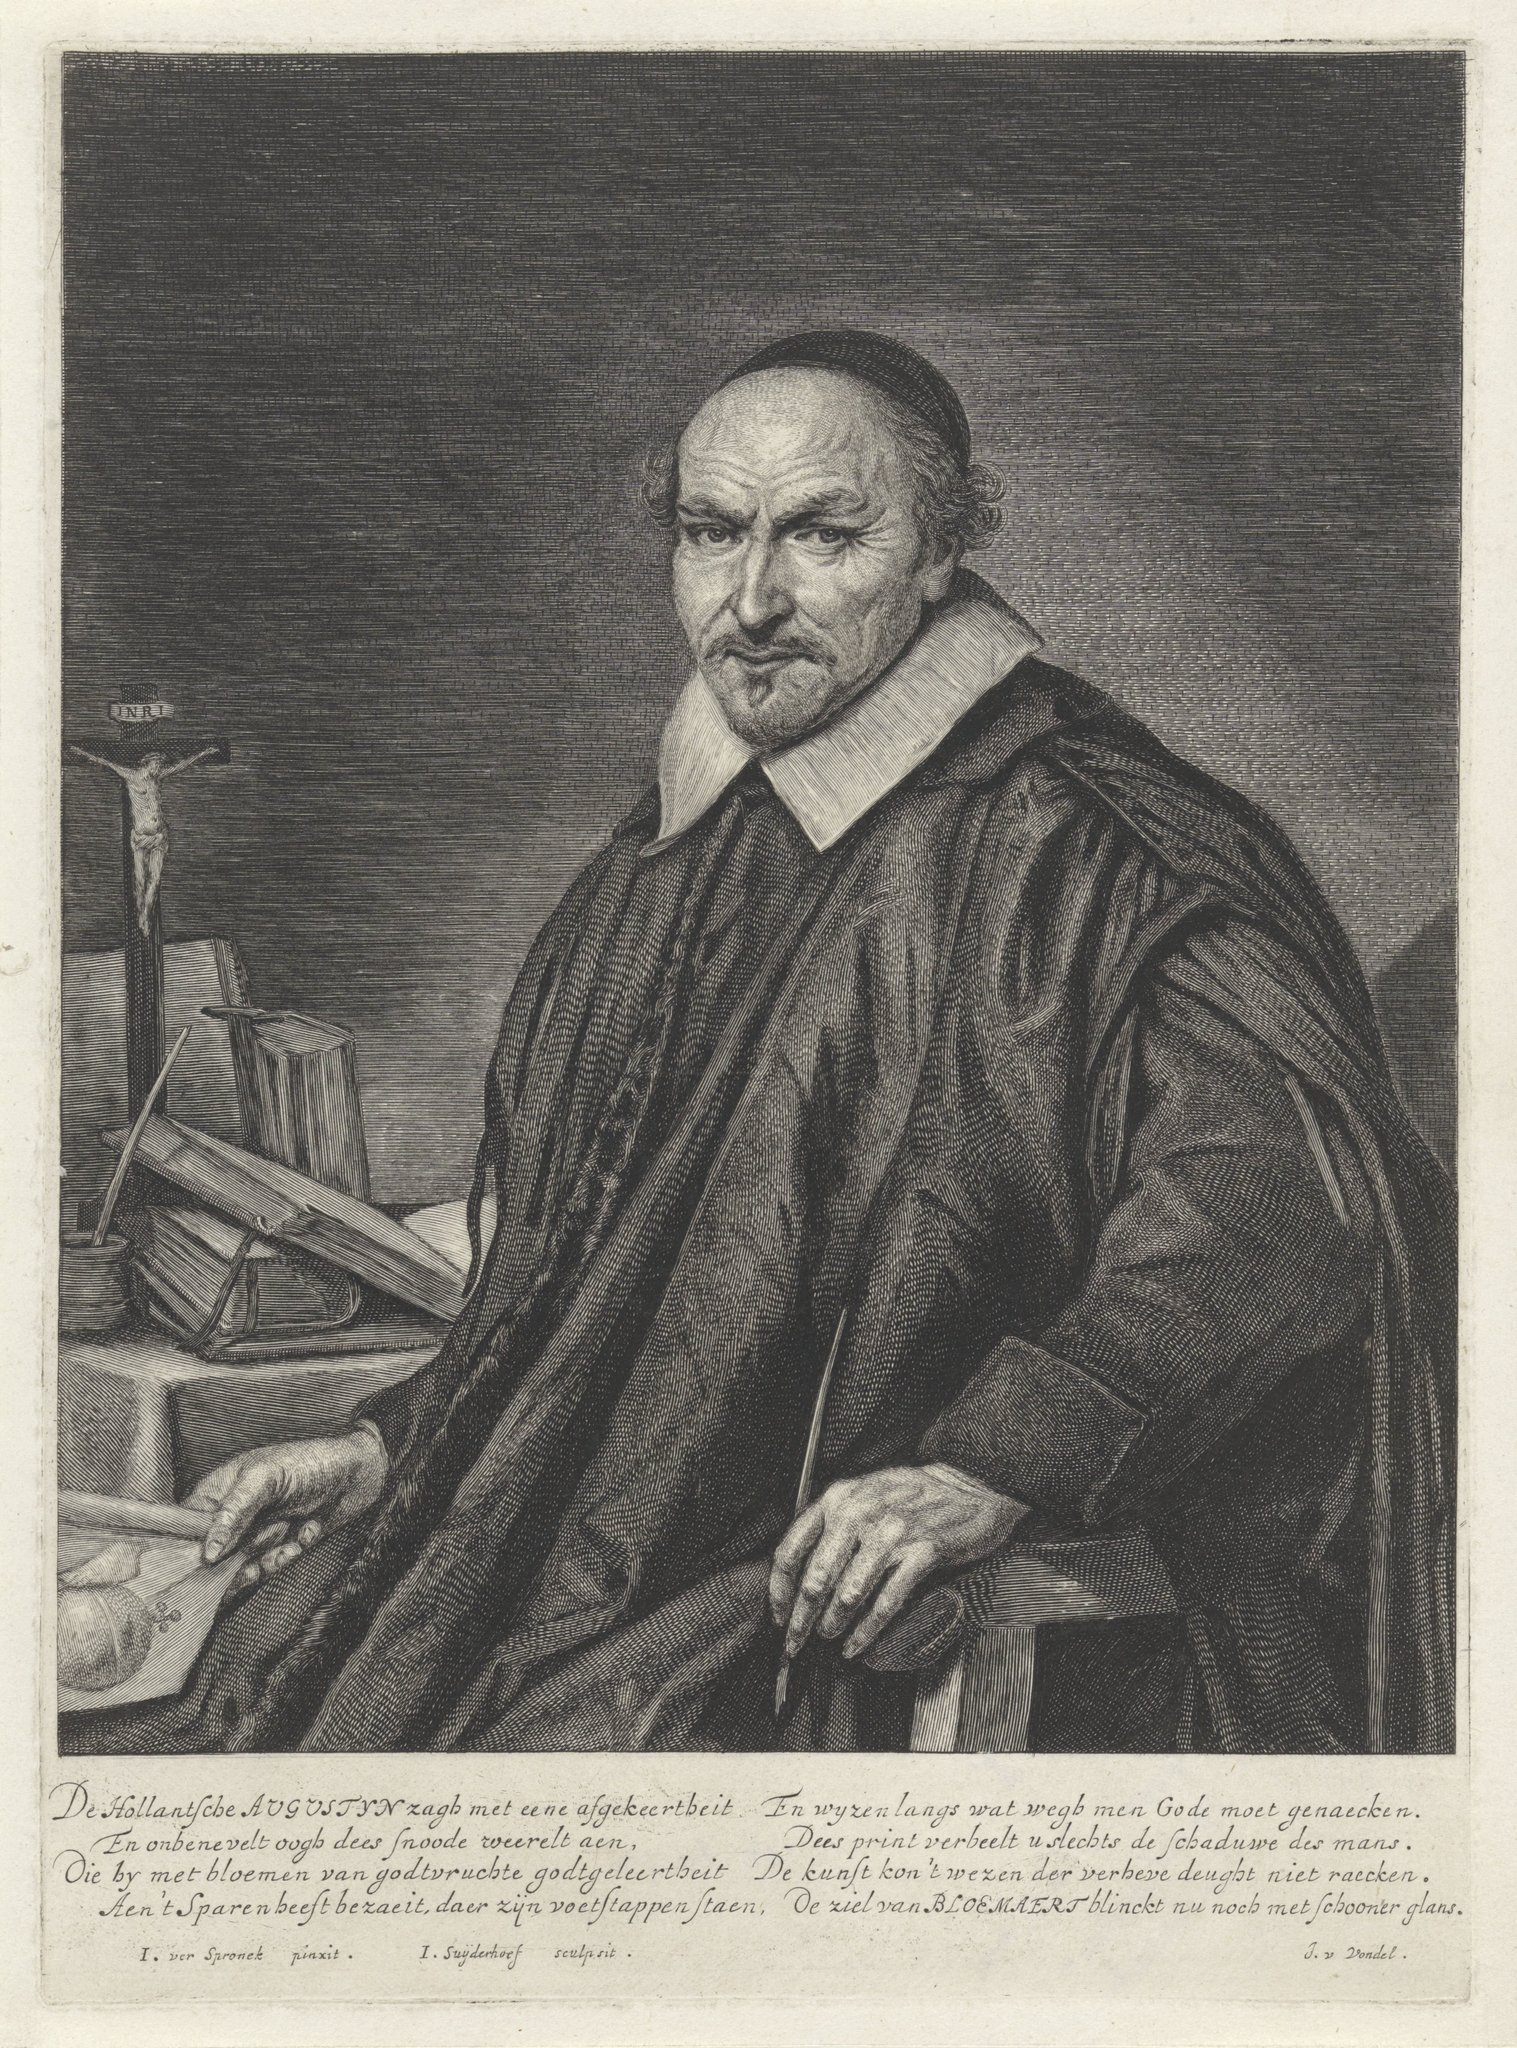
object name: print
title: Portret van Augustyn Alsten Bloemaert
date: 1623-1686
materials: paper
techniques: engraving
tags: organization, functionaries and dignitaries in roman catholic church; clergy in general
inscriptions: poem: ‘De Hollantsche AUGUSTYN zagh met eene afgekeertheit En onbenevelt oogh dees snoode weerelt aen, Die hy met bloemen van godtvruchte godtgeleertheit Aen 't Sparen heeft bezaeit, daer zijn voetstappen staen, En wijzen langs wat wegh men Gode moet genaecken. Dees print verbeelt u slechts de schaduwe des mans. De kunst kon 't wezen der verheve deught niet raecken. De ziel van BLOEMAERT blinckt nu noch met schooner glans.’, collector's mark: Lugt 240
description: Portret van pastoor Augustyn Alsten Bloemaert met een pen in de hand, gezeten bij tafel met boeken, inktpot en crucifix. Onderaan in de marge twee vierregelige verzen in het Nederlands.